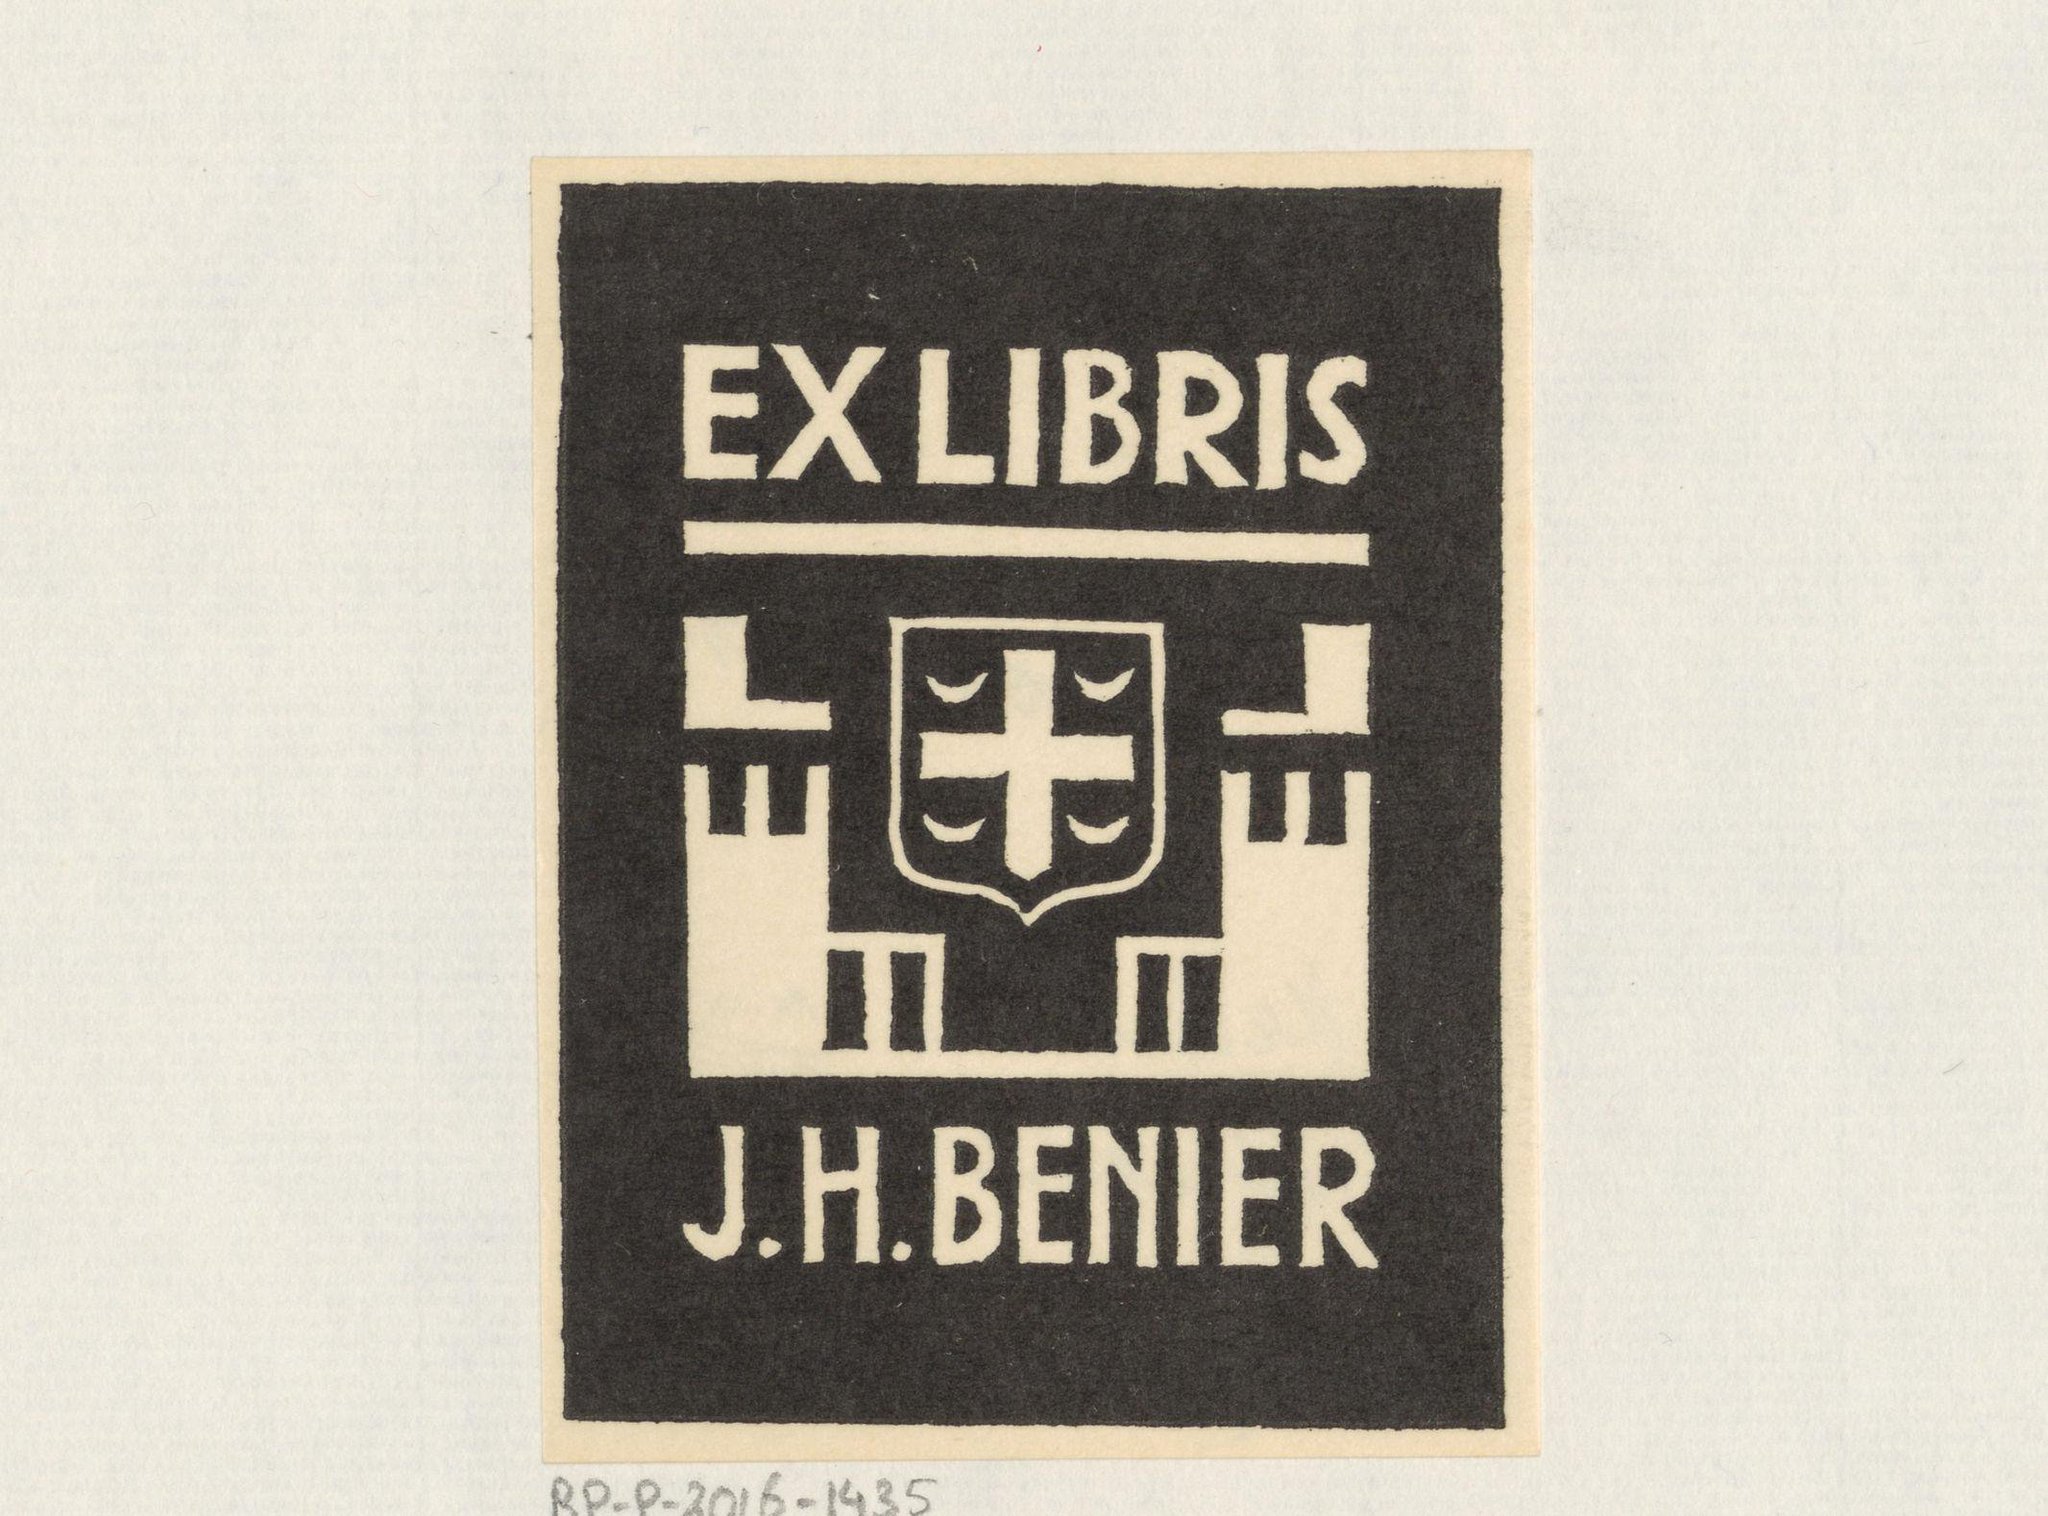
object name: bookplate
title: Ex libris van J.H. Benier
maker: jan kraan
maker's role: print maker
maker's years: 1901-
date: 1911-1971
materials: paper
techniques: linocut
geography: utrecht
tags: civic architecture; edifices; dwellings